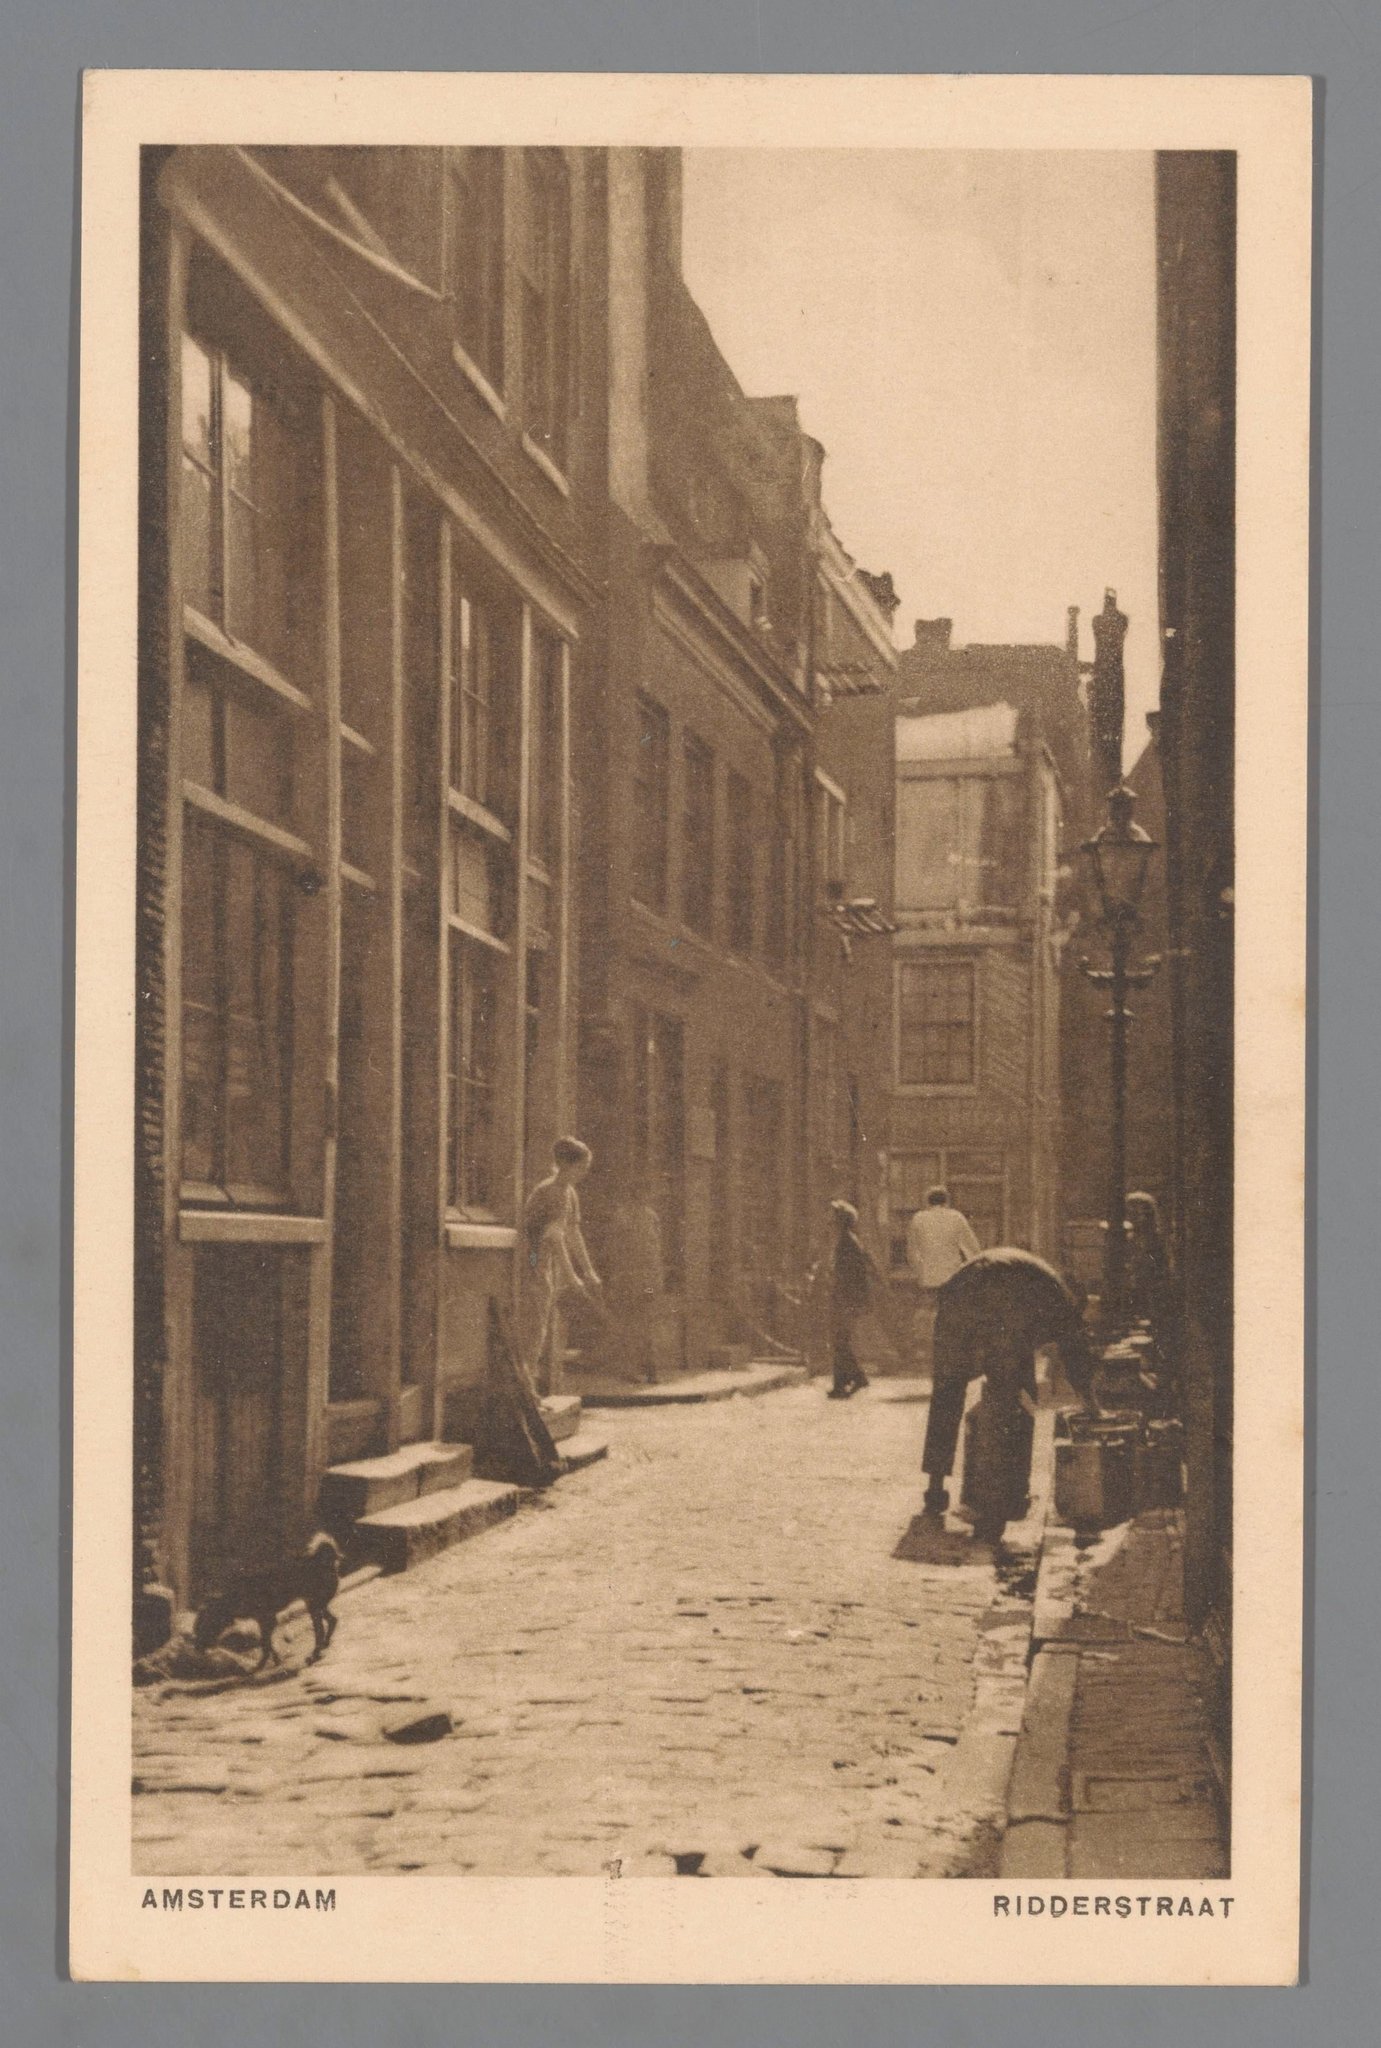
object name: ansichtkaart, prentbriefkaart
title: Amsterdam. Ridderstraat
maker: Anonymous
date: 1875-1930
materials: cardboard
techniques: photograph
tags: street, amsterdam